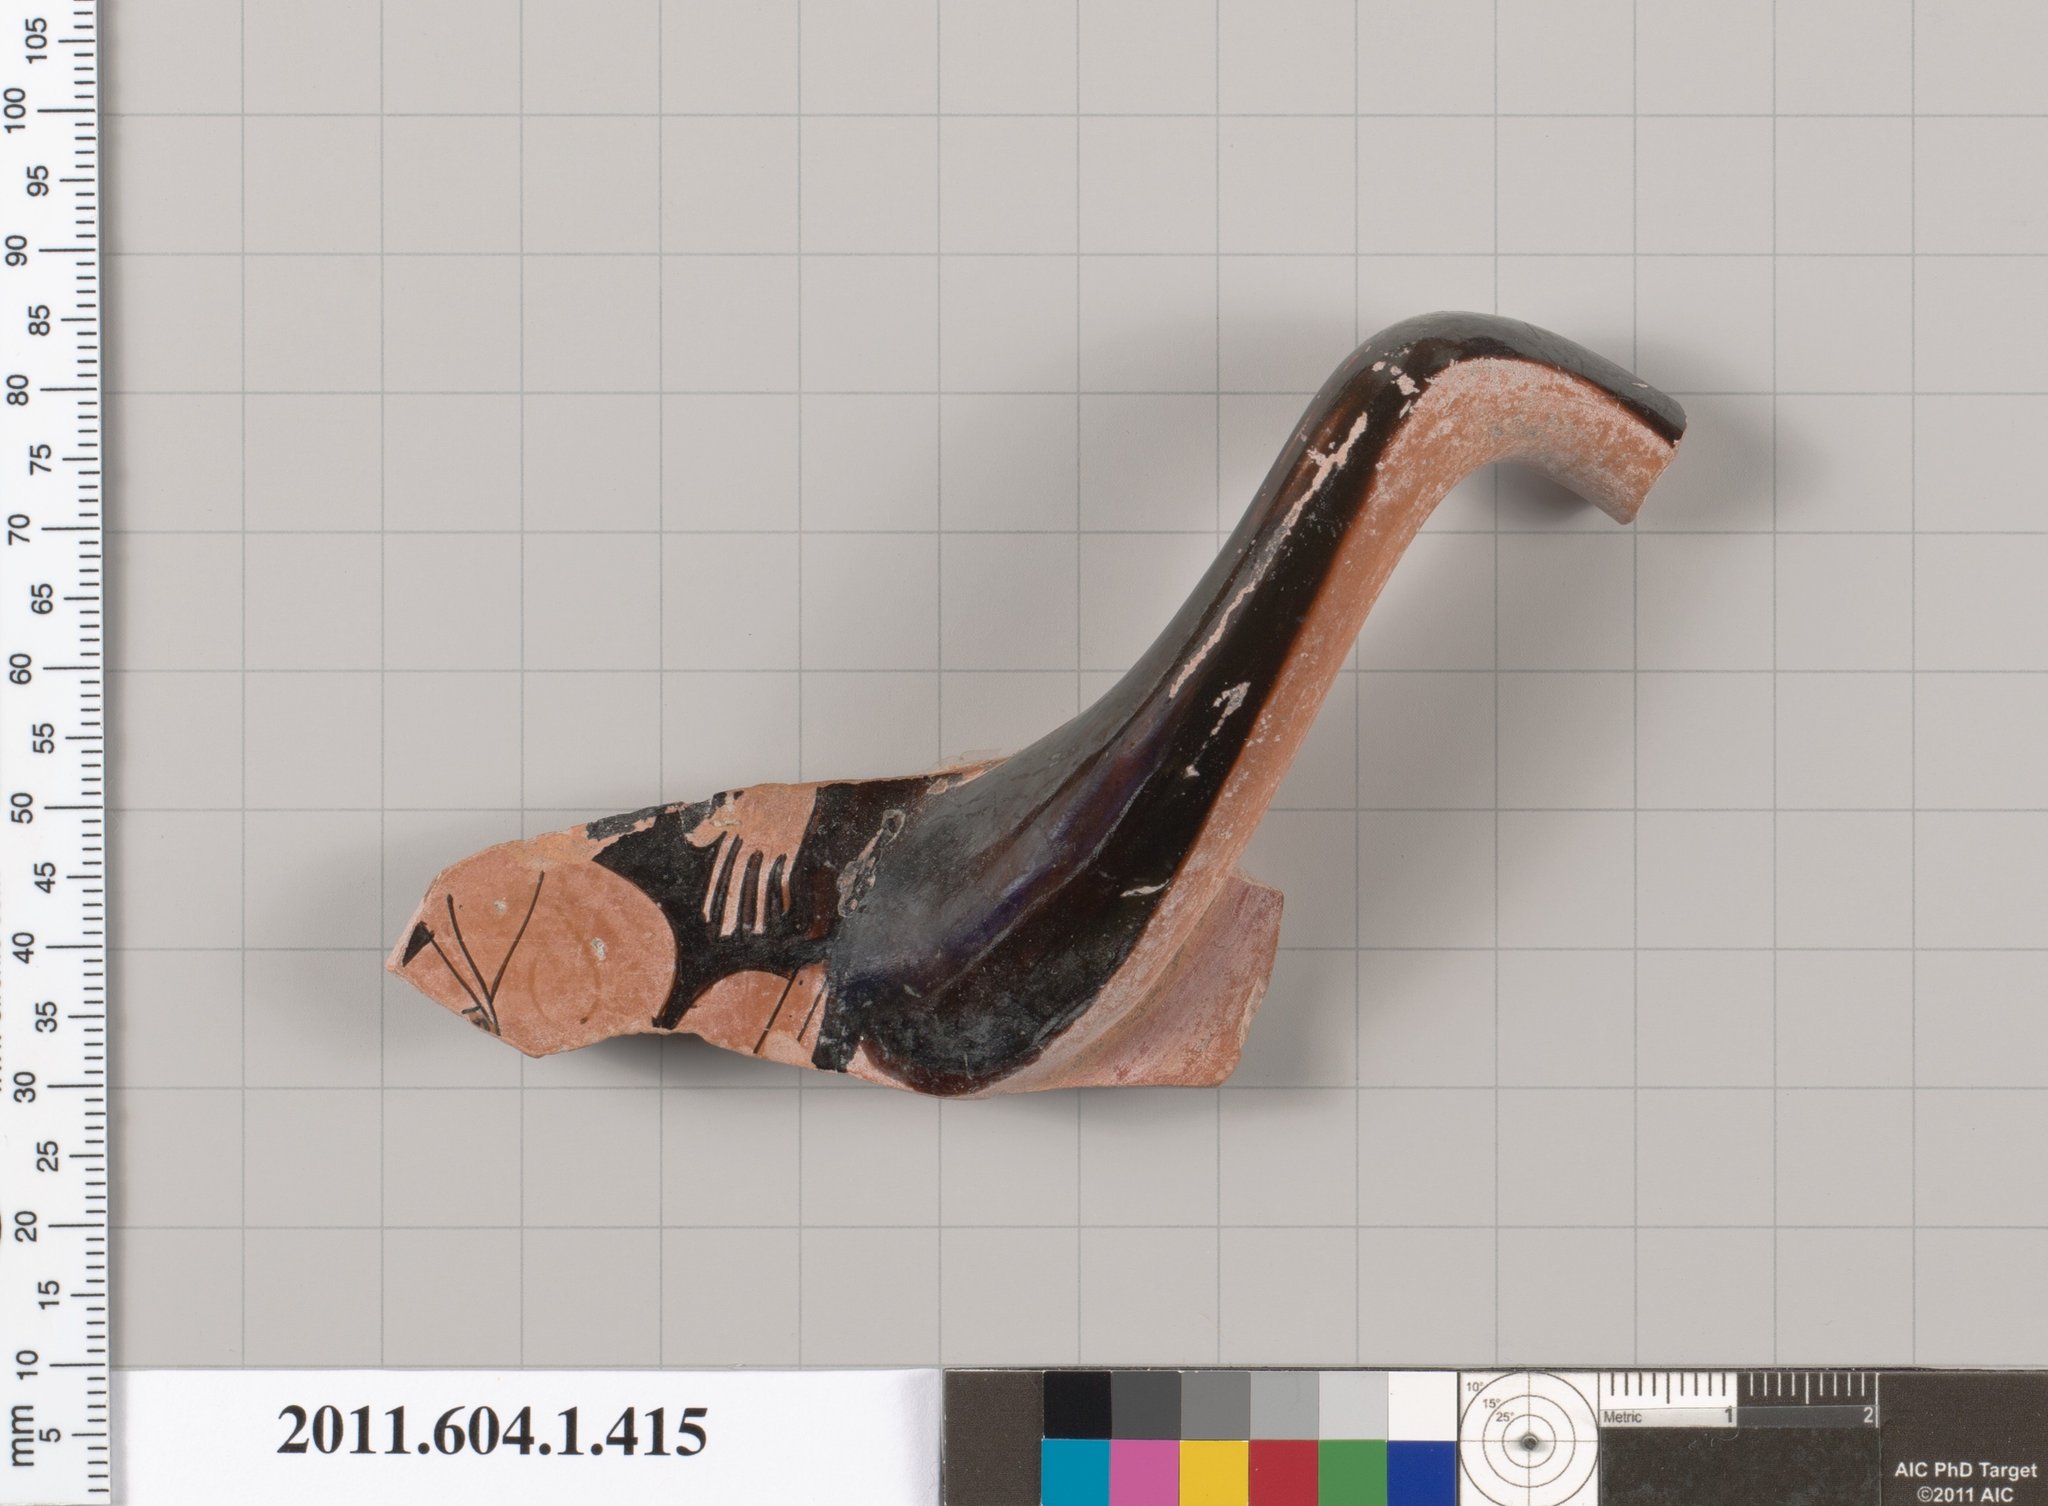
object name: kylix fragment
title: Terracotta fragment of a kylix (drinking cup)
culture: greek, attic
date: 475-451 BCE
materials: terracotta